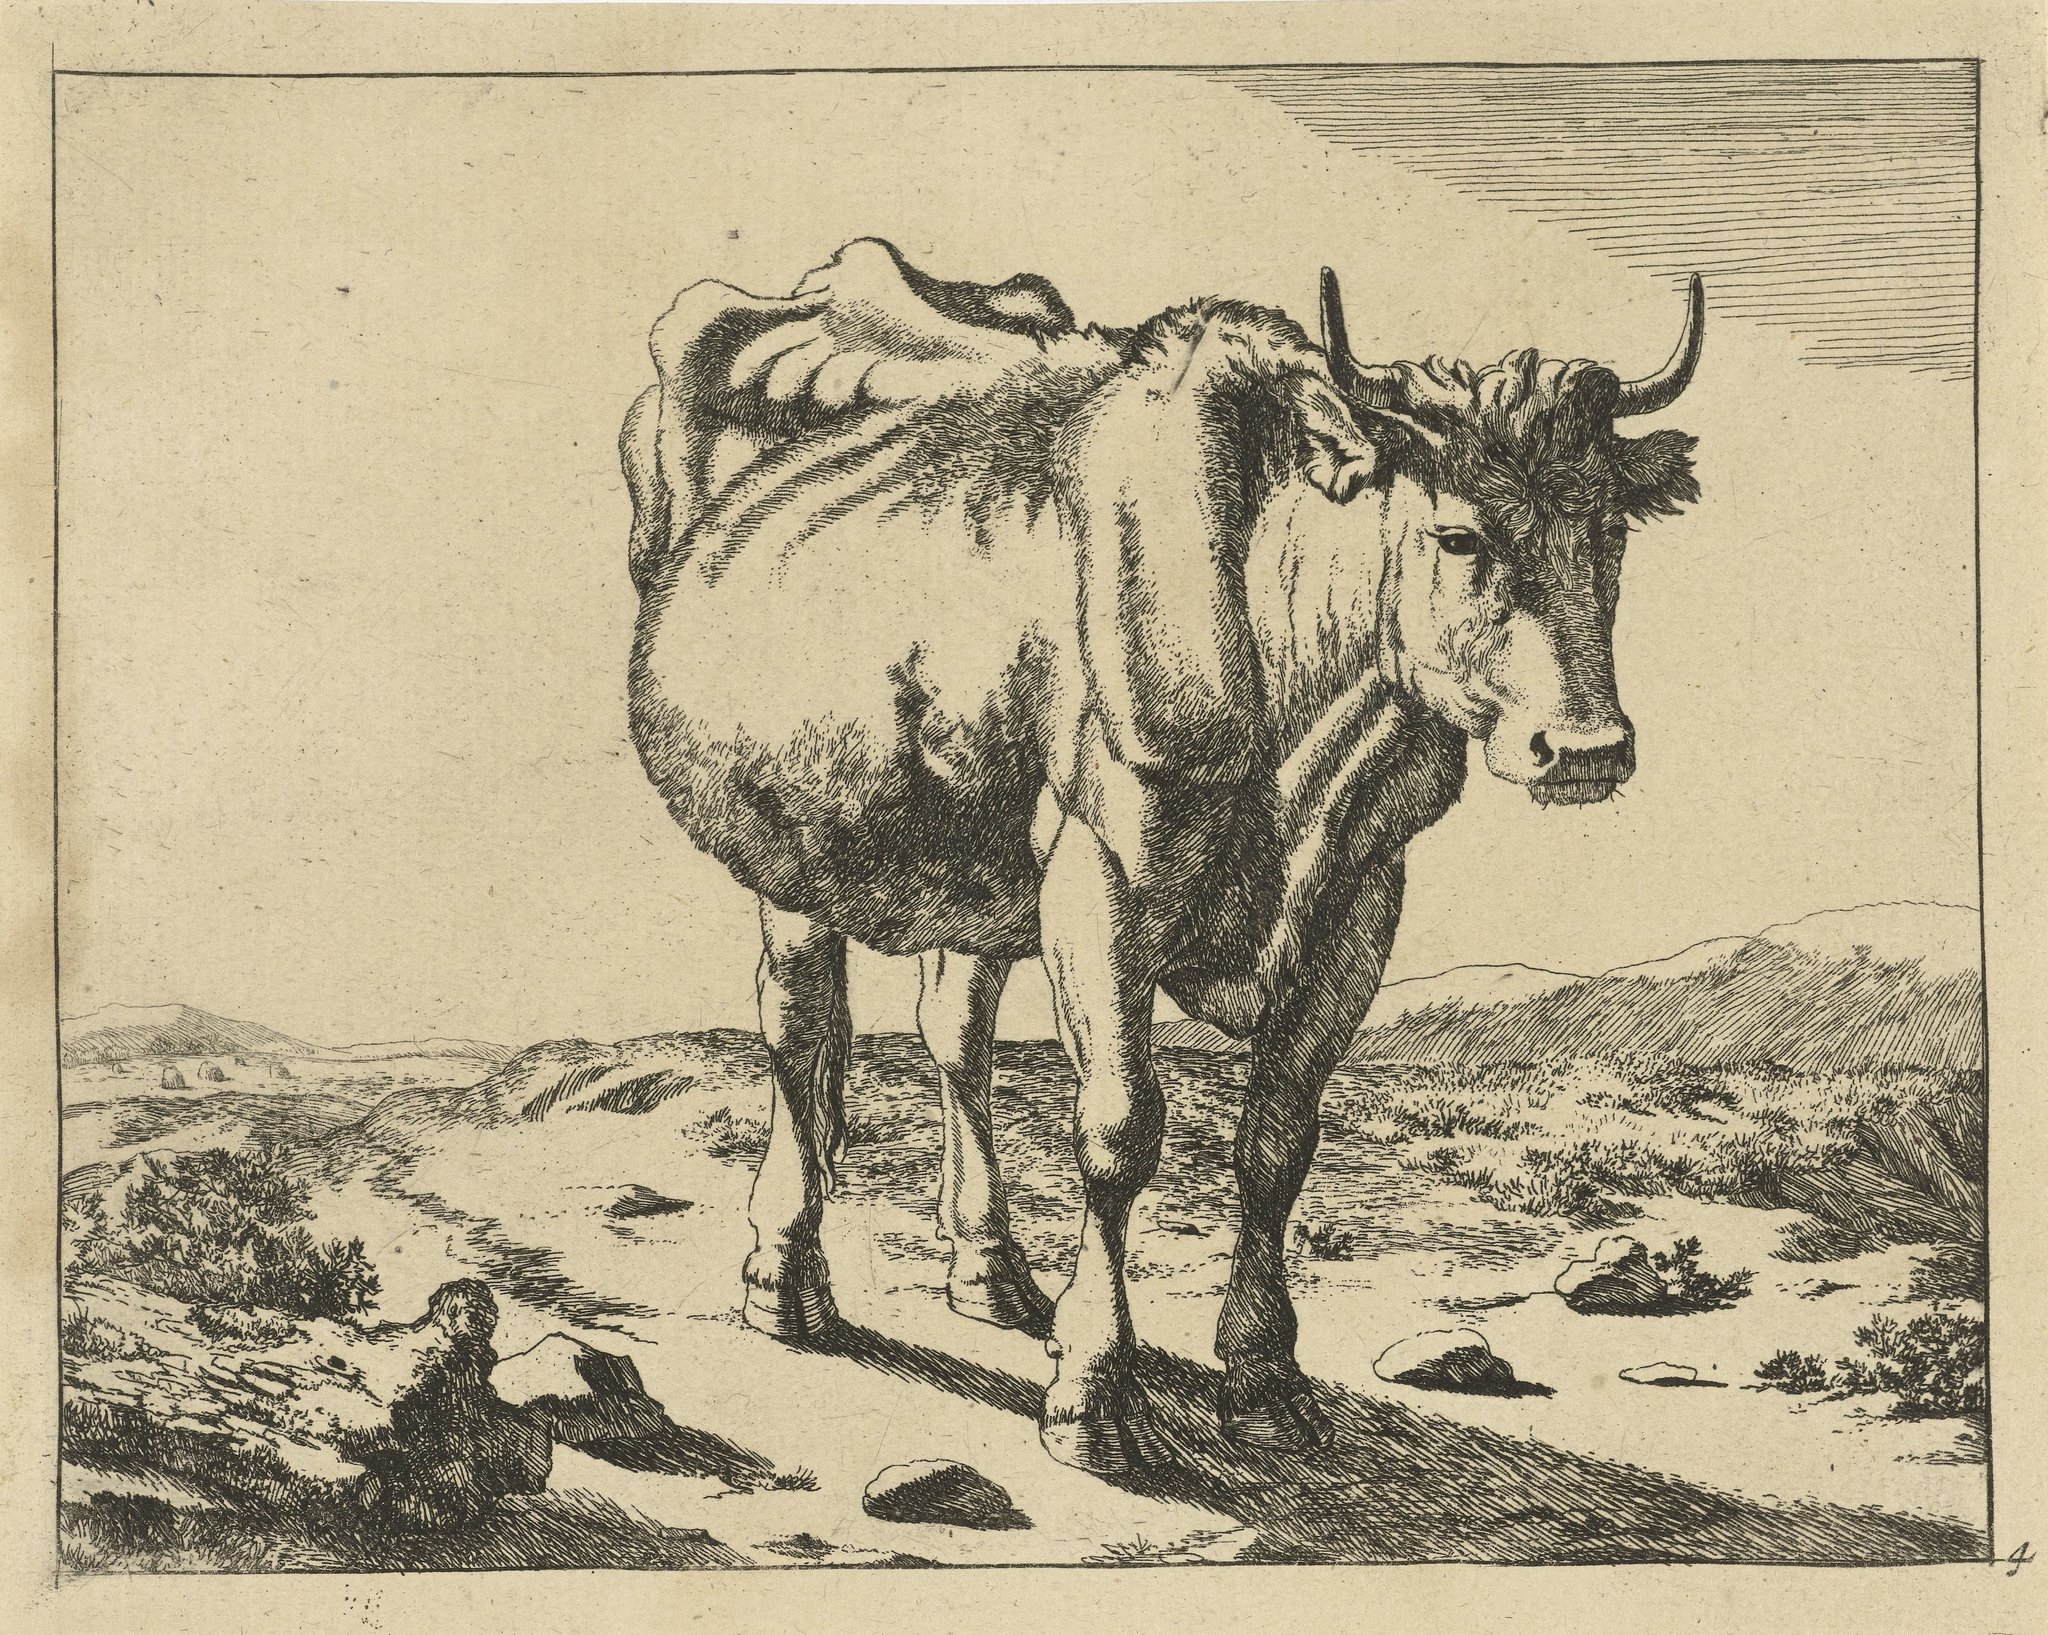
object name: print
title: Runderen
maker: marcus de bye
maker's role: print maker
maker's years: 1639-1688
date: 1657-1677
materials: paper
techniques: etching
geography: the hague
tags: cow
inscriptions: collector's mark: Lugt 2228